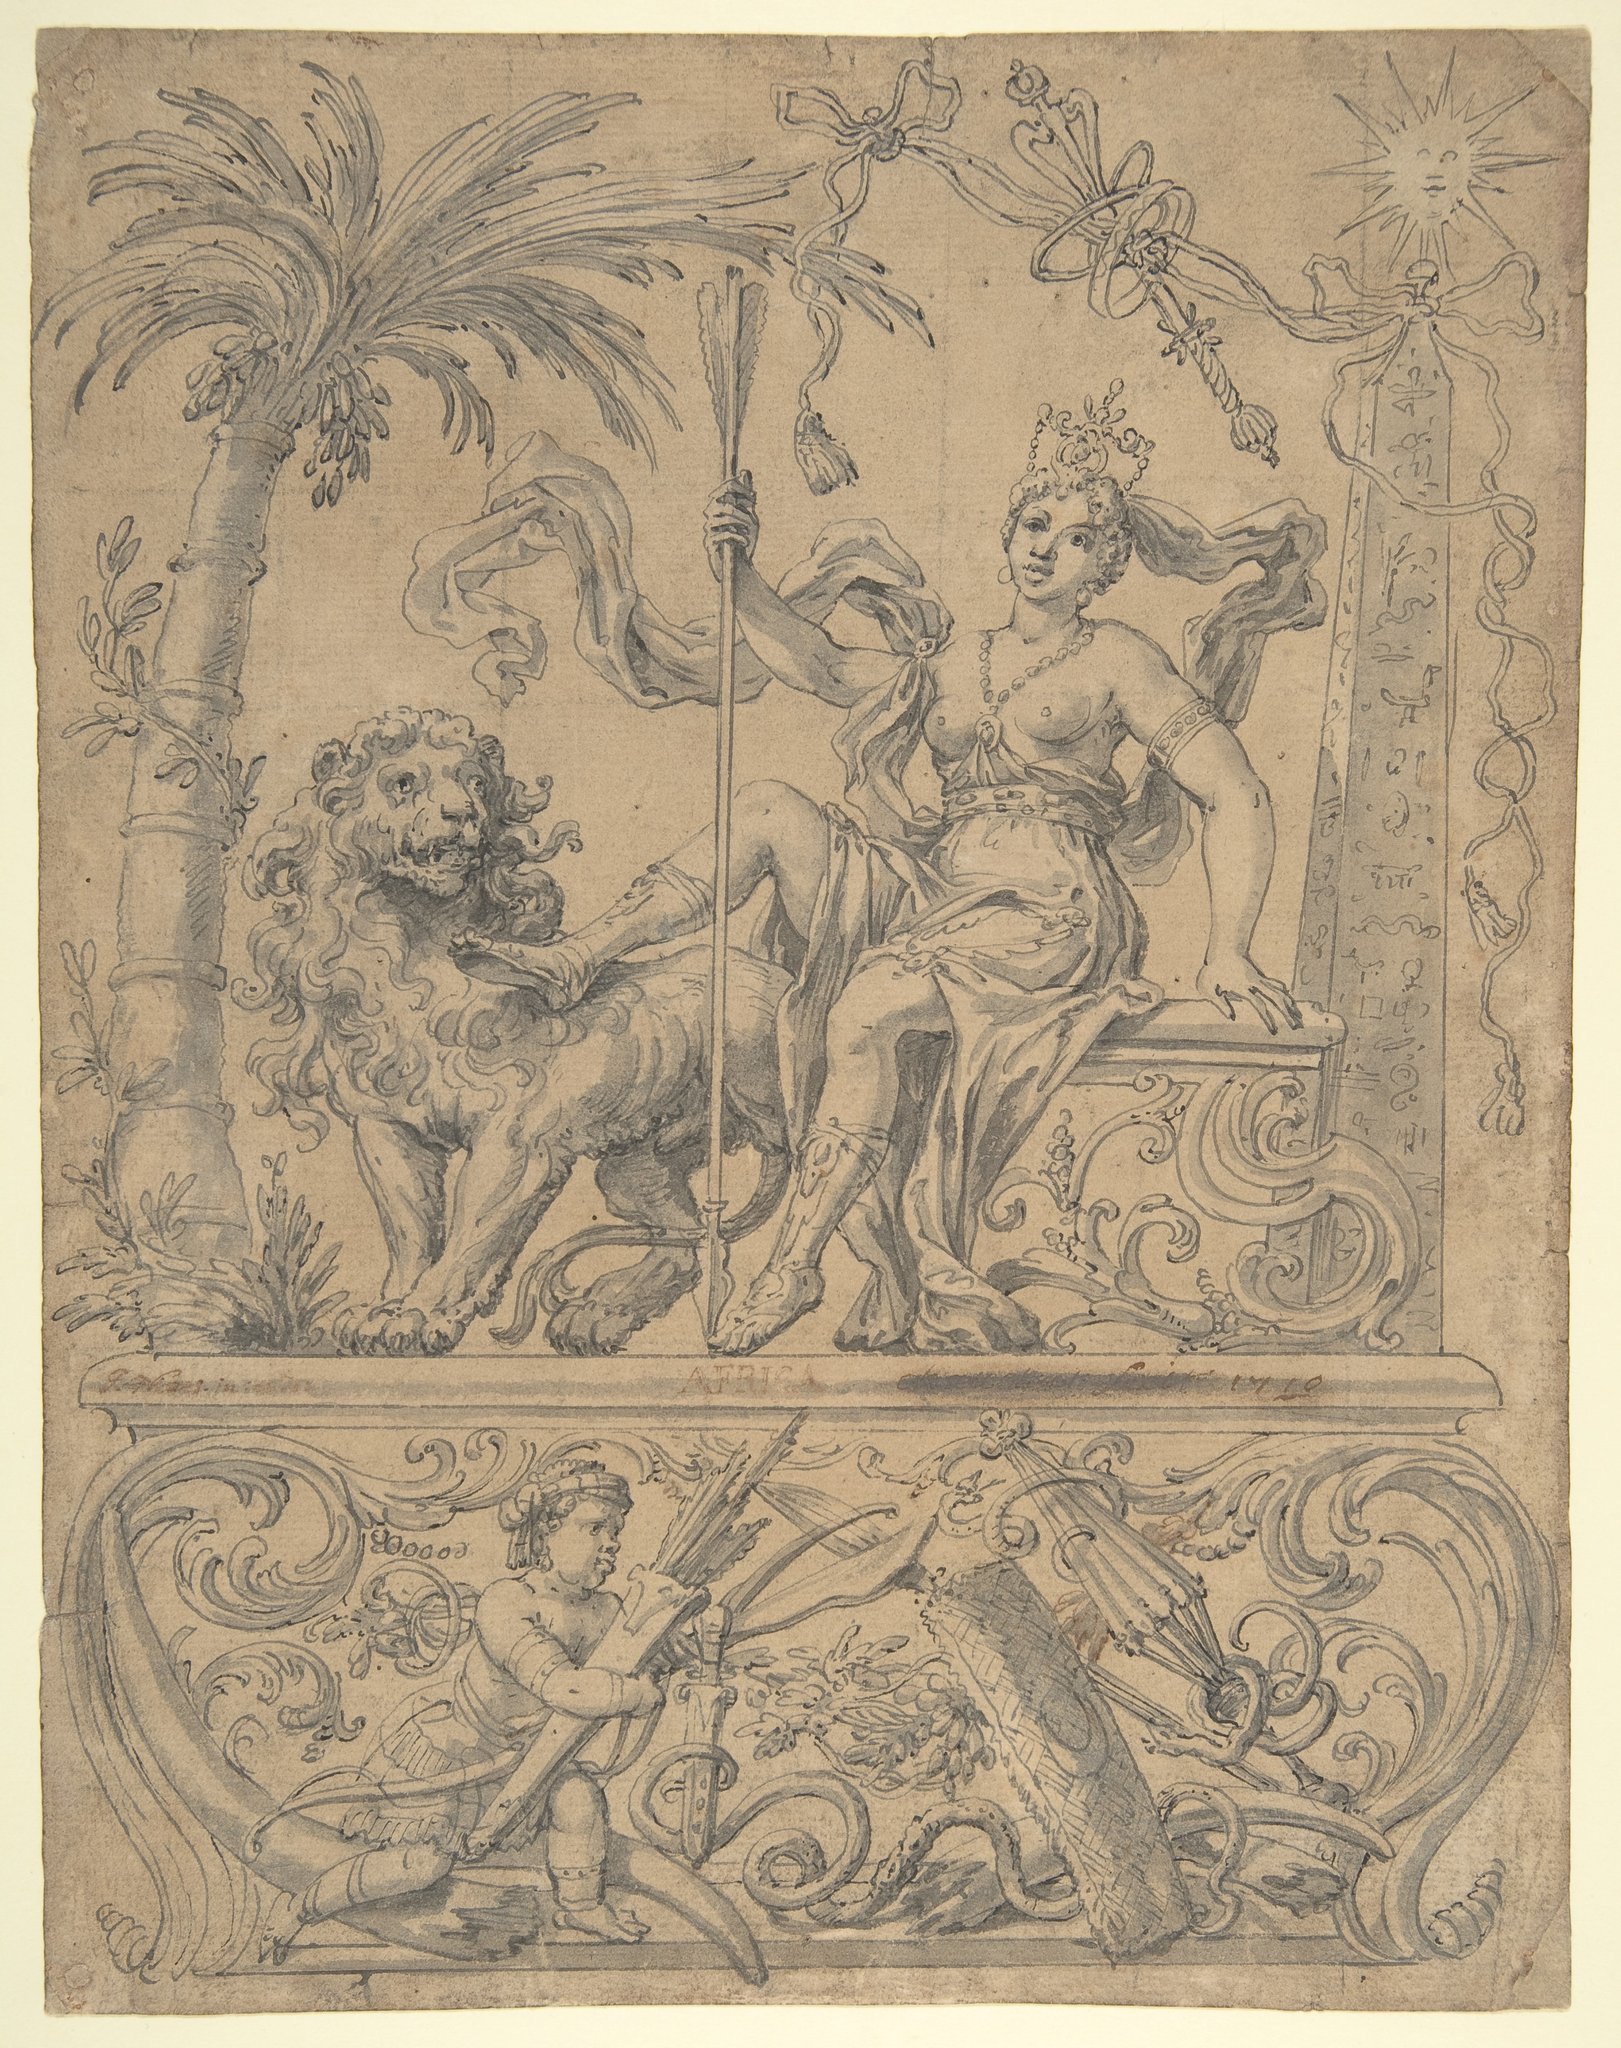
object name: drawing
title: Allegory of Africa, from the Four Continents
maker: godfried maes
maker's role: artist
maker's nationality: flemish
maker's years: 1649-1700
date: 1601-1700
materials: ink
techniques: brush, pen, wash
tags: bow and arrow,spears,women,lions,trees